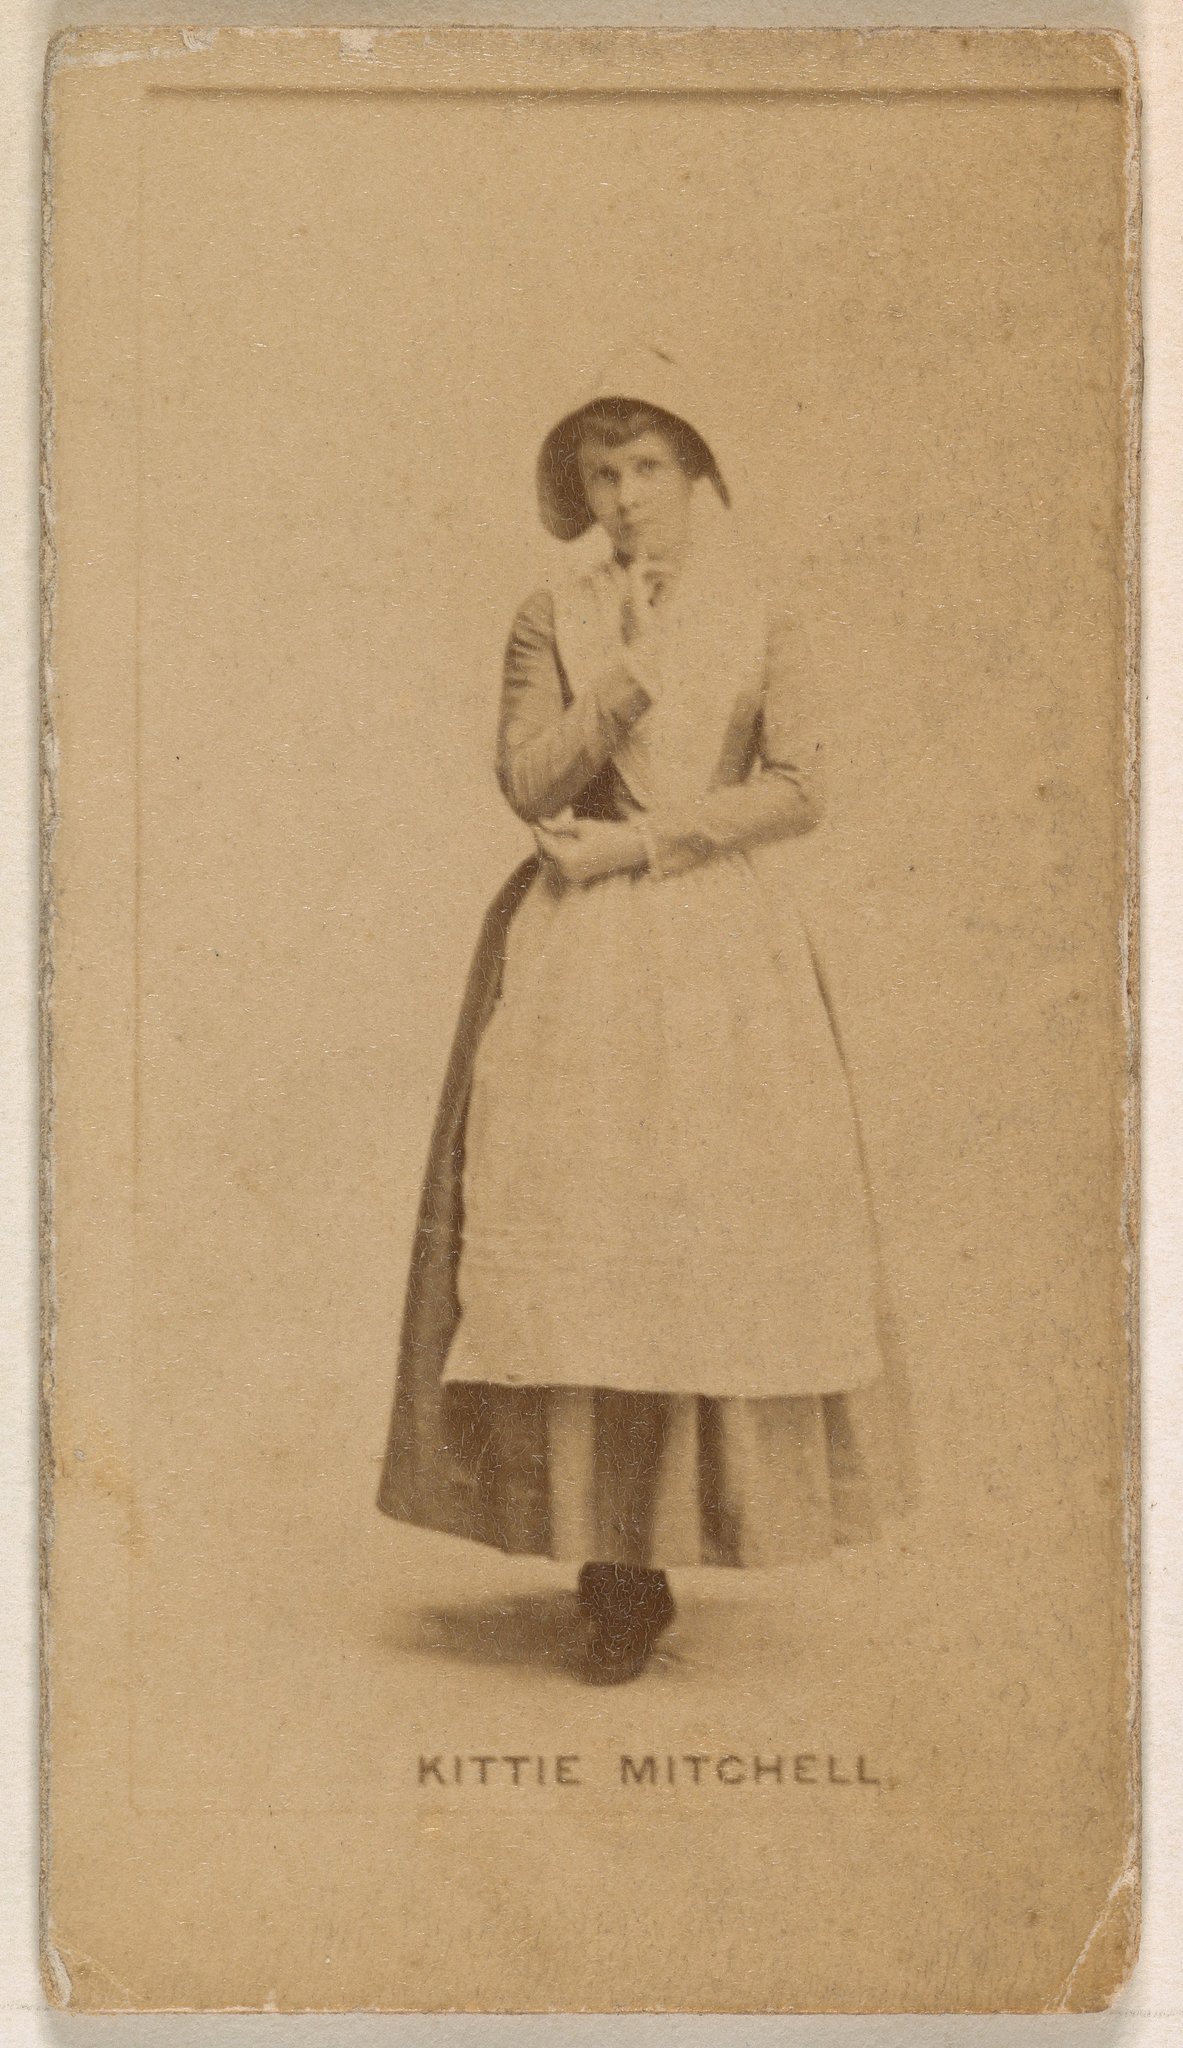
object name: photograph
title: Kittie Mitchell, from the Actresses series (N245) issued by Kinney Brothers to promote Sweet Caporal Cigarettes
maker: kinney brothers tobacco company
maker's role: publisher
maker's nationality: american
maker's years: 1869-2011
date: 1890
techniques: albumen silver print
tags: portraits,women,actresses